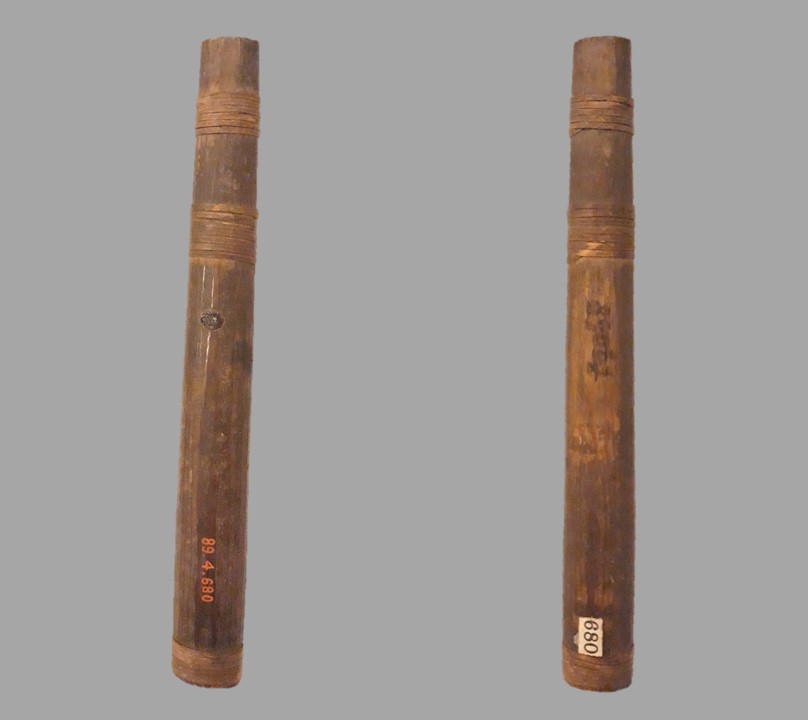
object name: reed pipe lateral retreating reed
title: Reed Pipe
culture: native american, haida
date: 1801-1900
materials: wood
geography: canada